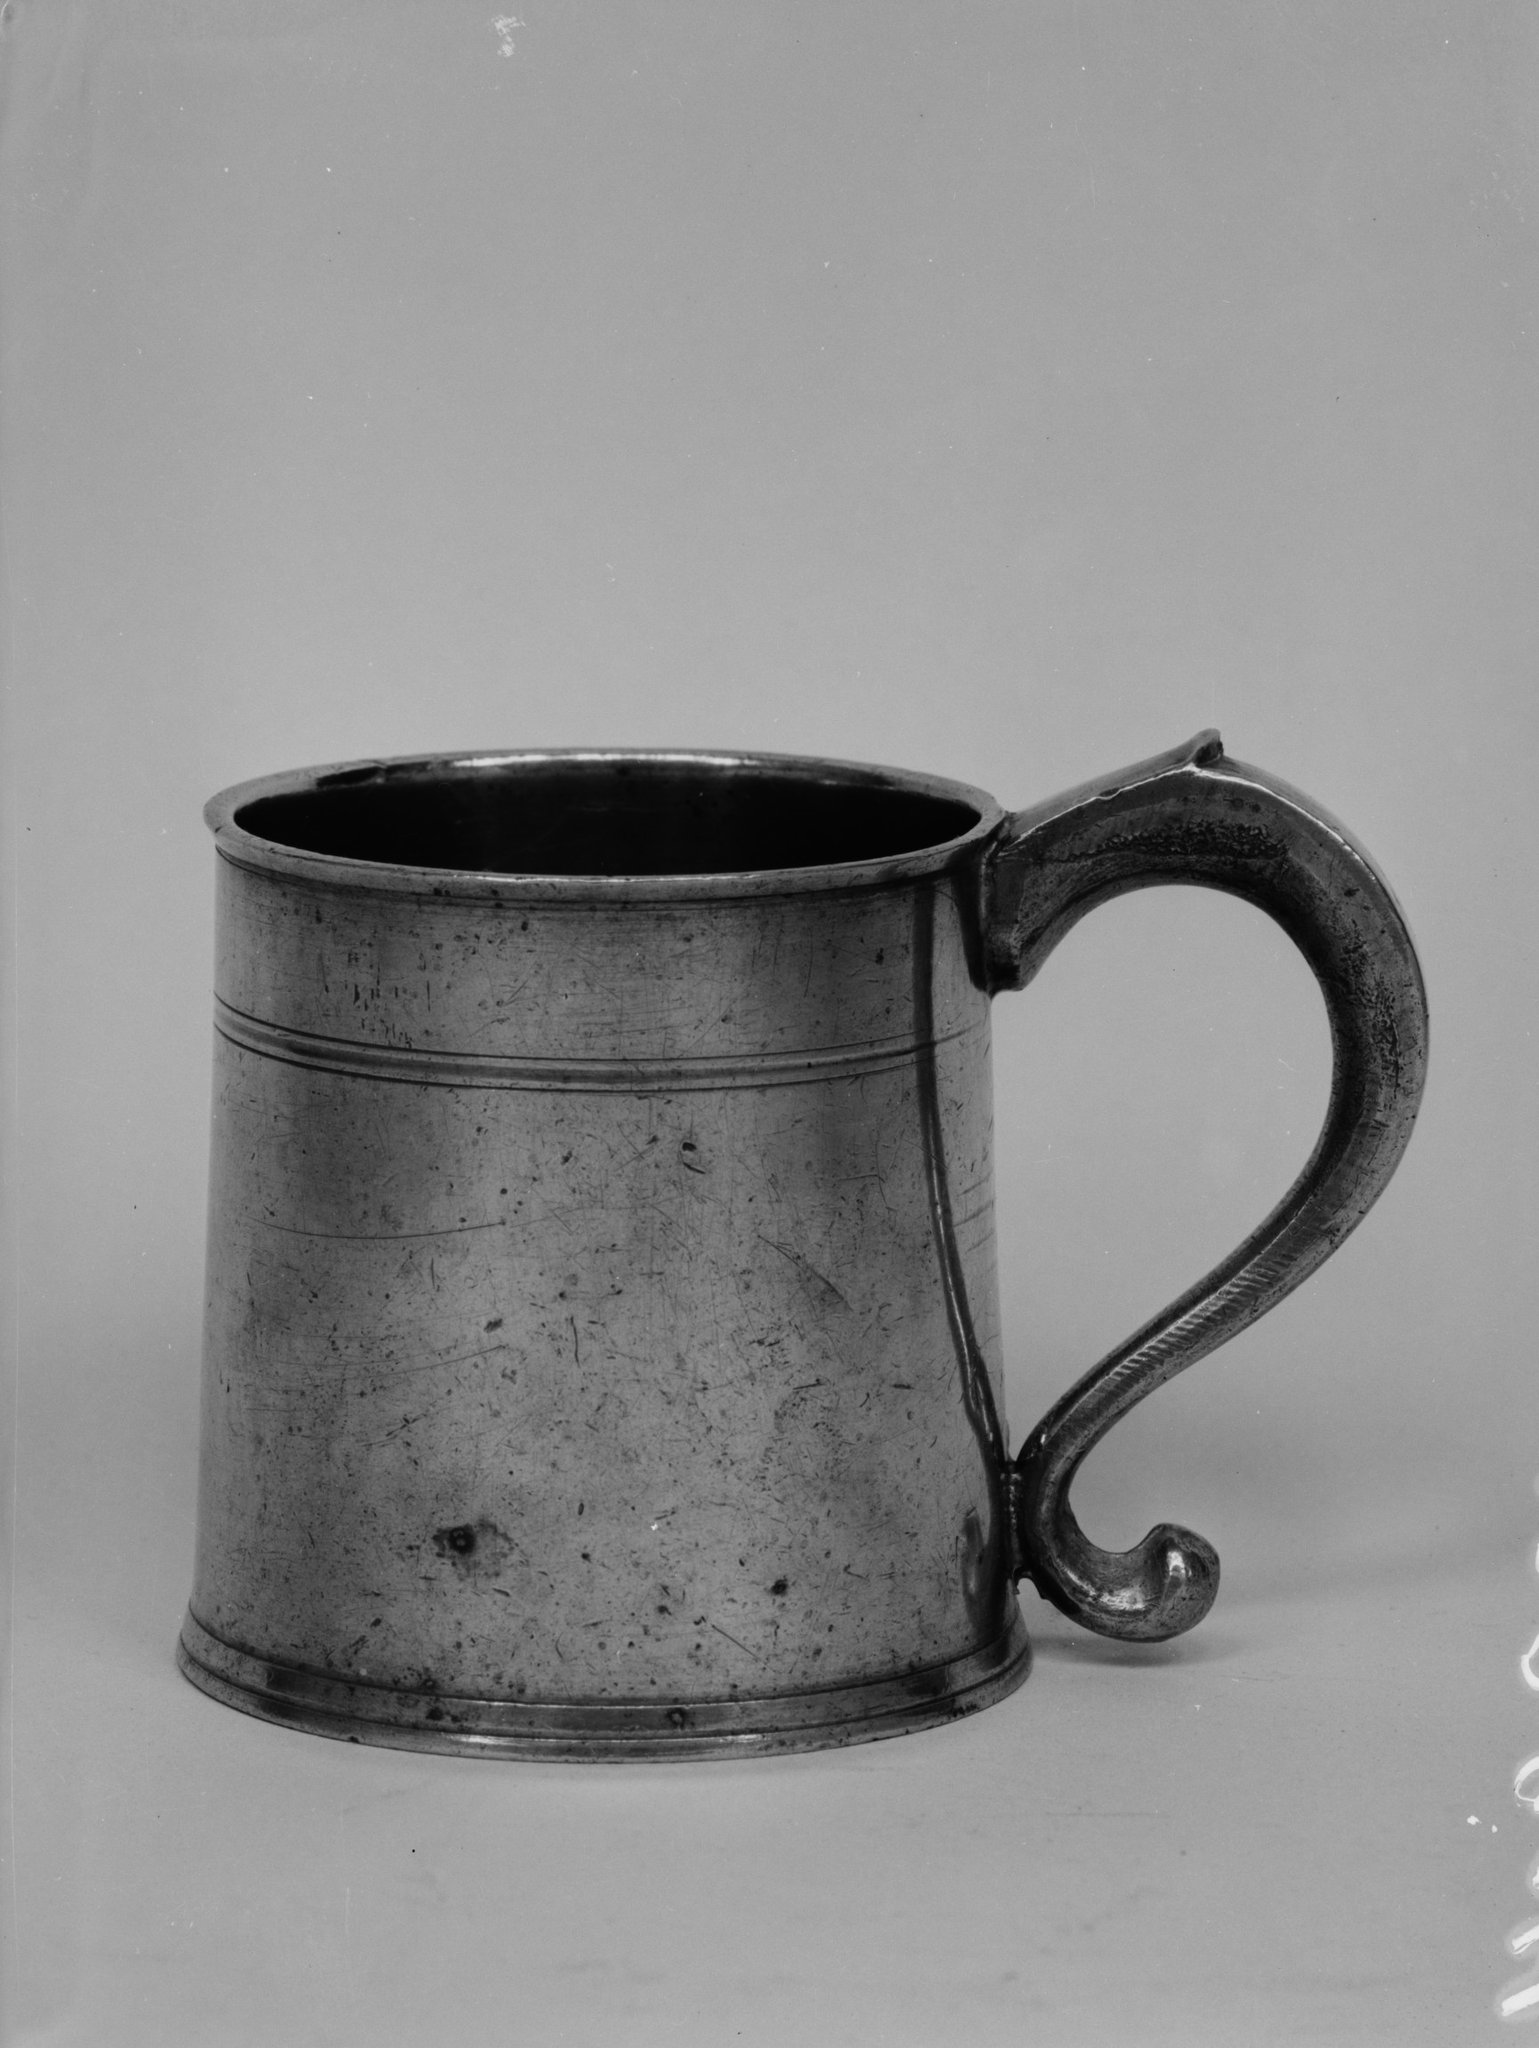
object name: mug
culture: american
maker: samuel danforth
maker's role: maker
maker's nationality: american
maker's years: 1774-1816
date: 1795-1816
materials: pewter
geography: united states